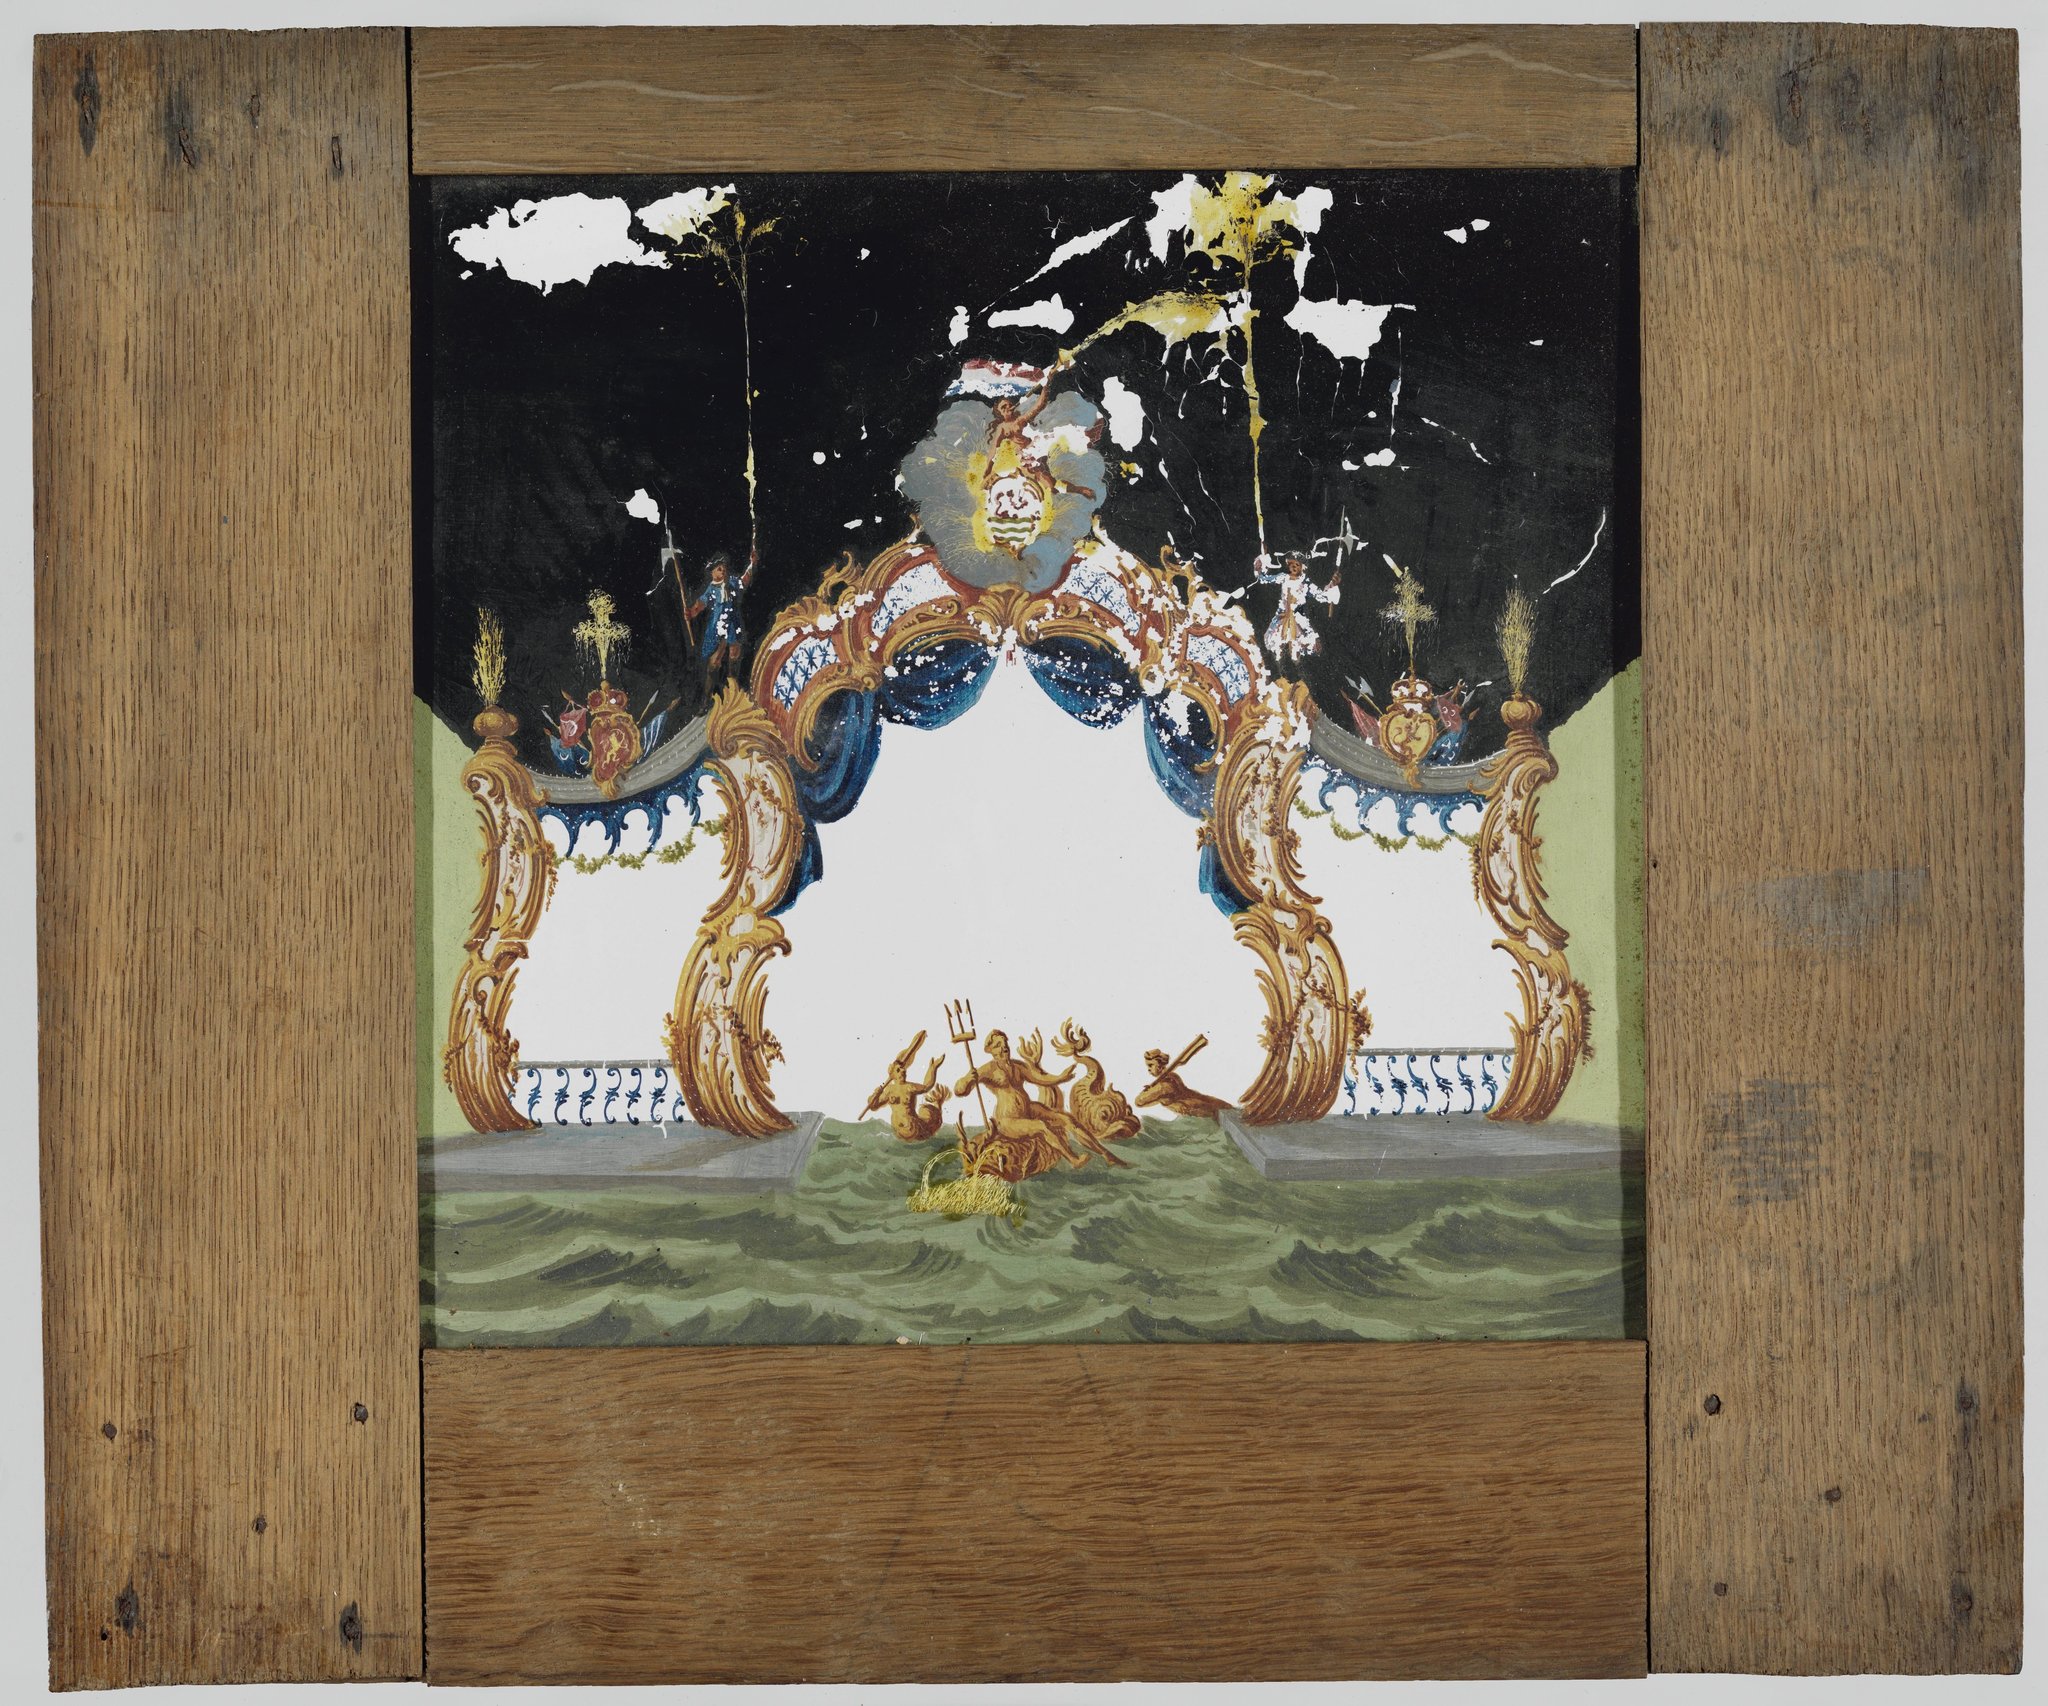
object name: diafanoramaplaat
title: Diafanorama van Neptunus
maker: Anonymous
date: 1750-1830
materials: glass, wood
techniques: painted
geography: netherlands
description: Op de voorgrond is Neptunus op een vis zichtbaar, met daarnaast twee zeemeerminnen en nog een vis. Links en recht is een soort van hekwerk, deze loopt door tot het plafond. Boven in het midden is een Hollandse vlag zichtbaar. Het midden is onbeschilderd.